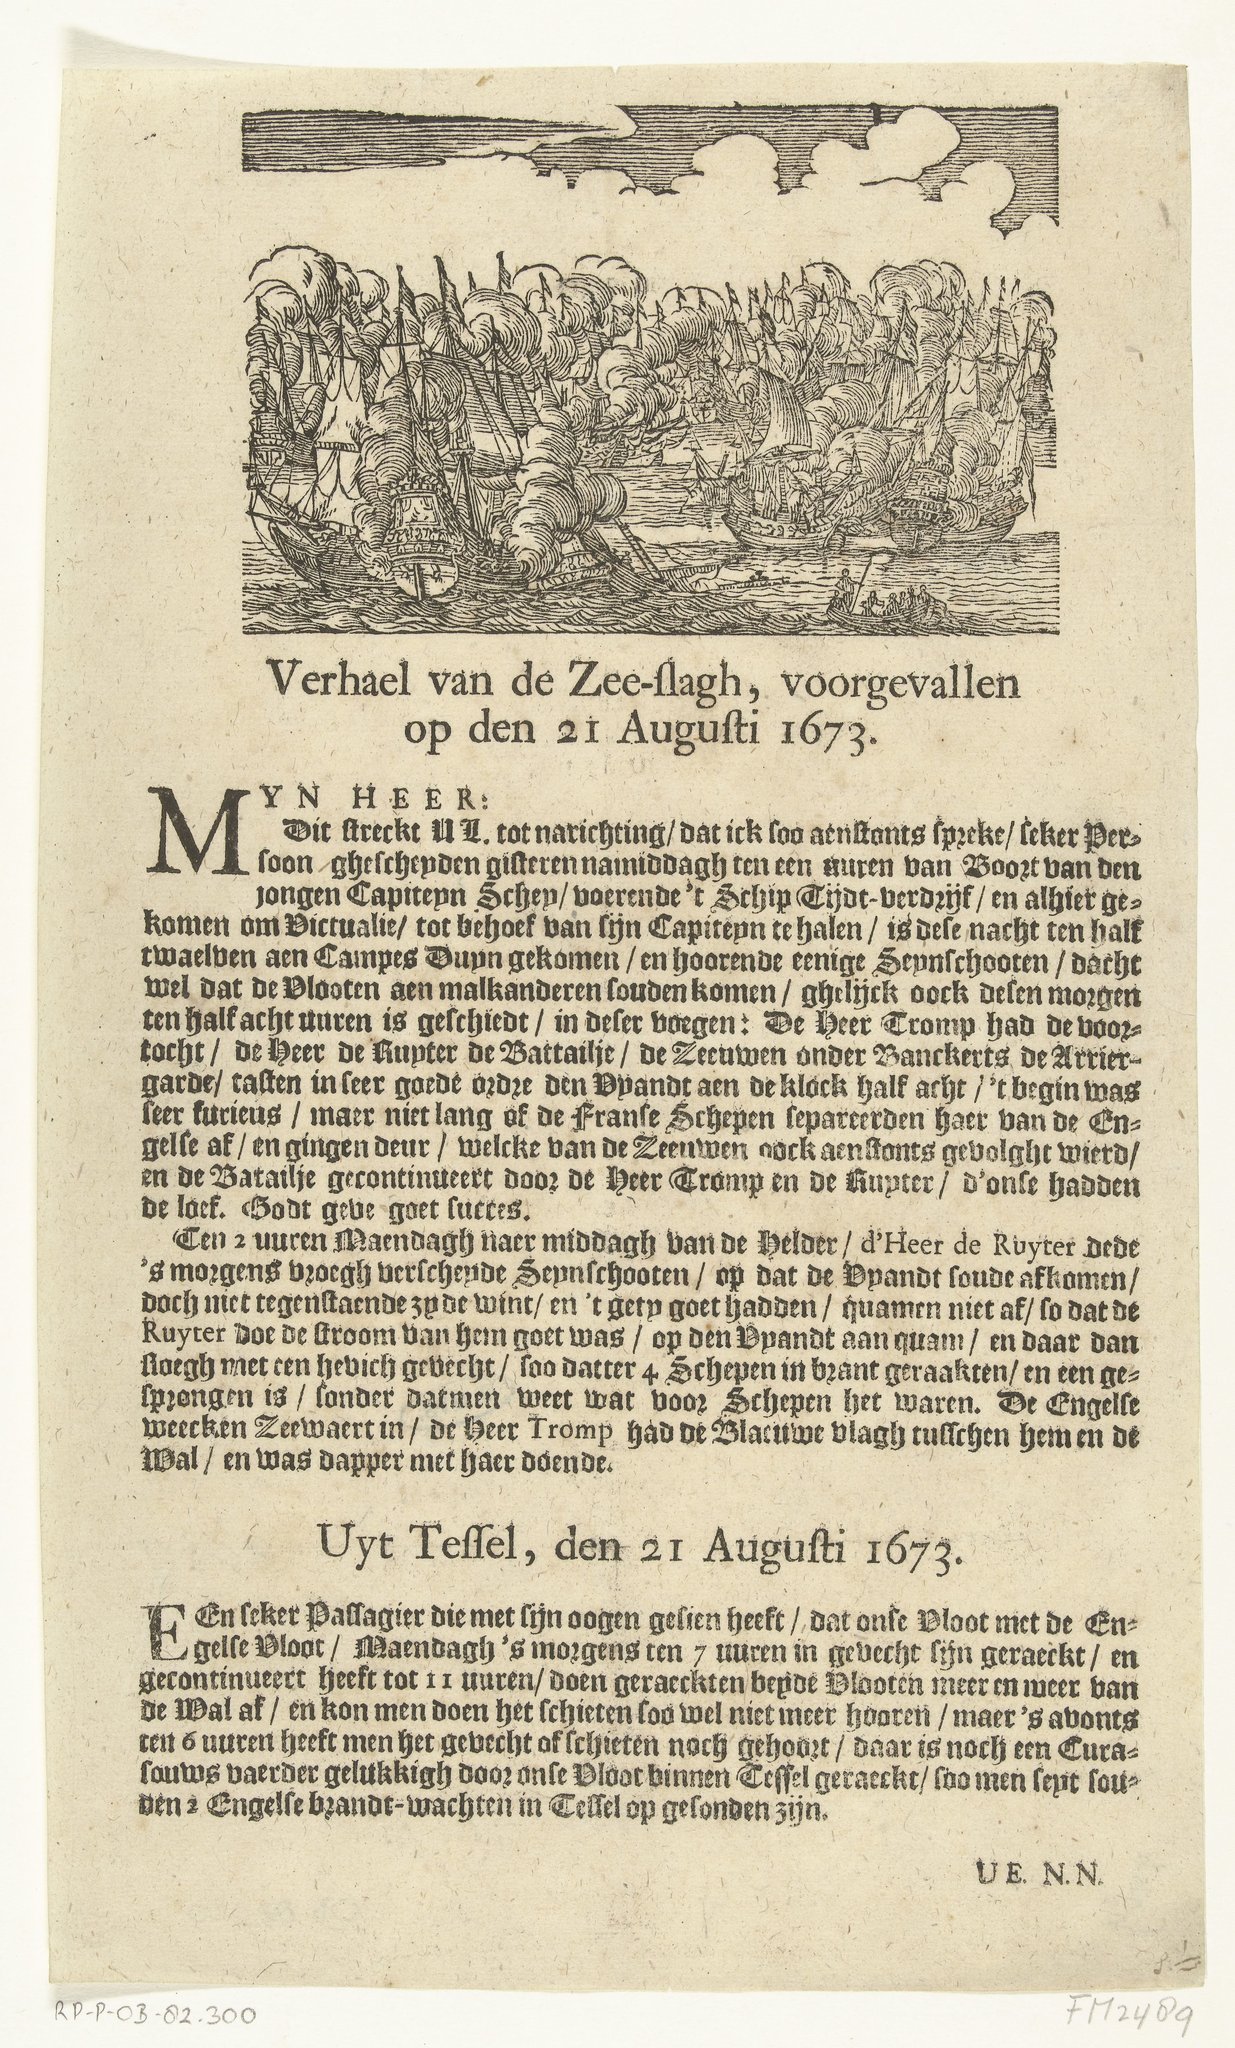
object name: print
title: Verhael van de Zee-slagh, voorgevallen op den 21 Augusti 1673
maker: Anonymous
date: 1673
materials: paper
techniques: letterpress printing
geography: northern netherlands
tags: painter, print maker, prinz ruprecht, flushing, michiel adriaenszoon de ruyter, amsterdam, cornelis tromp, battle (+ naval force), battle of the texel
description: Zeeslag bij Kijkduin (bij Texel) op 21 augustus 1673 tussen de Staatse vloot onder Michiel Adriaenszoon de Ruyter en Cornelis Tromp en de Engels-Franse vloot onder prins Rupert en graaf Jean d'Estrées (II). Blad geïllustreerd met een fragment van een oude houtsnede van een zeeslag. De tekst daaronder bestat uit twee brieven aangaande het verloop van de strijd.